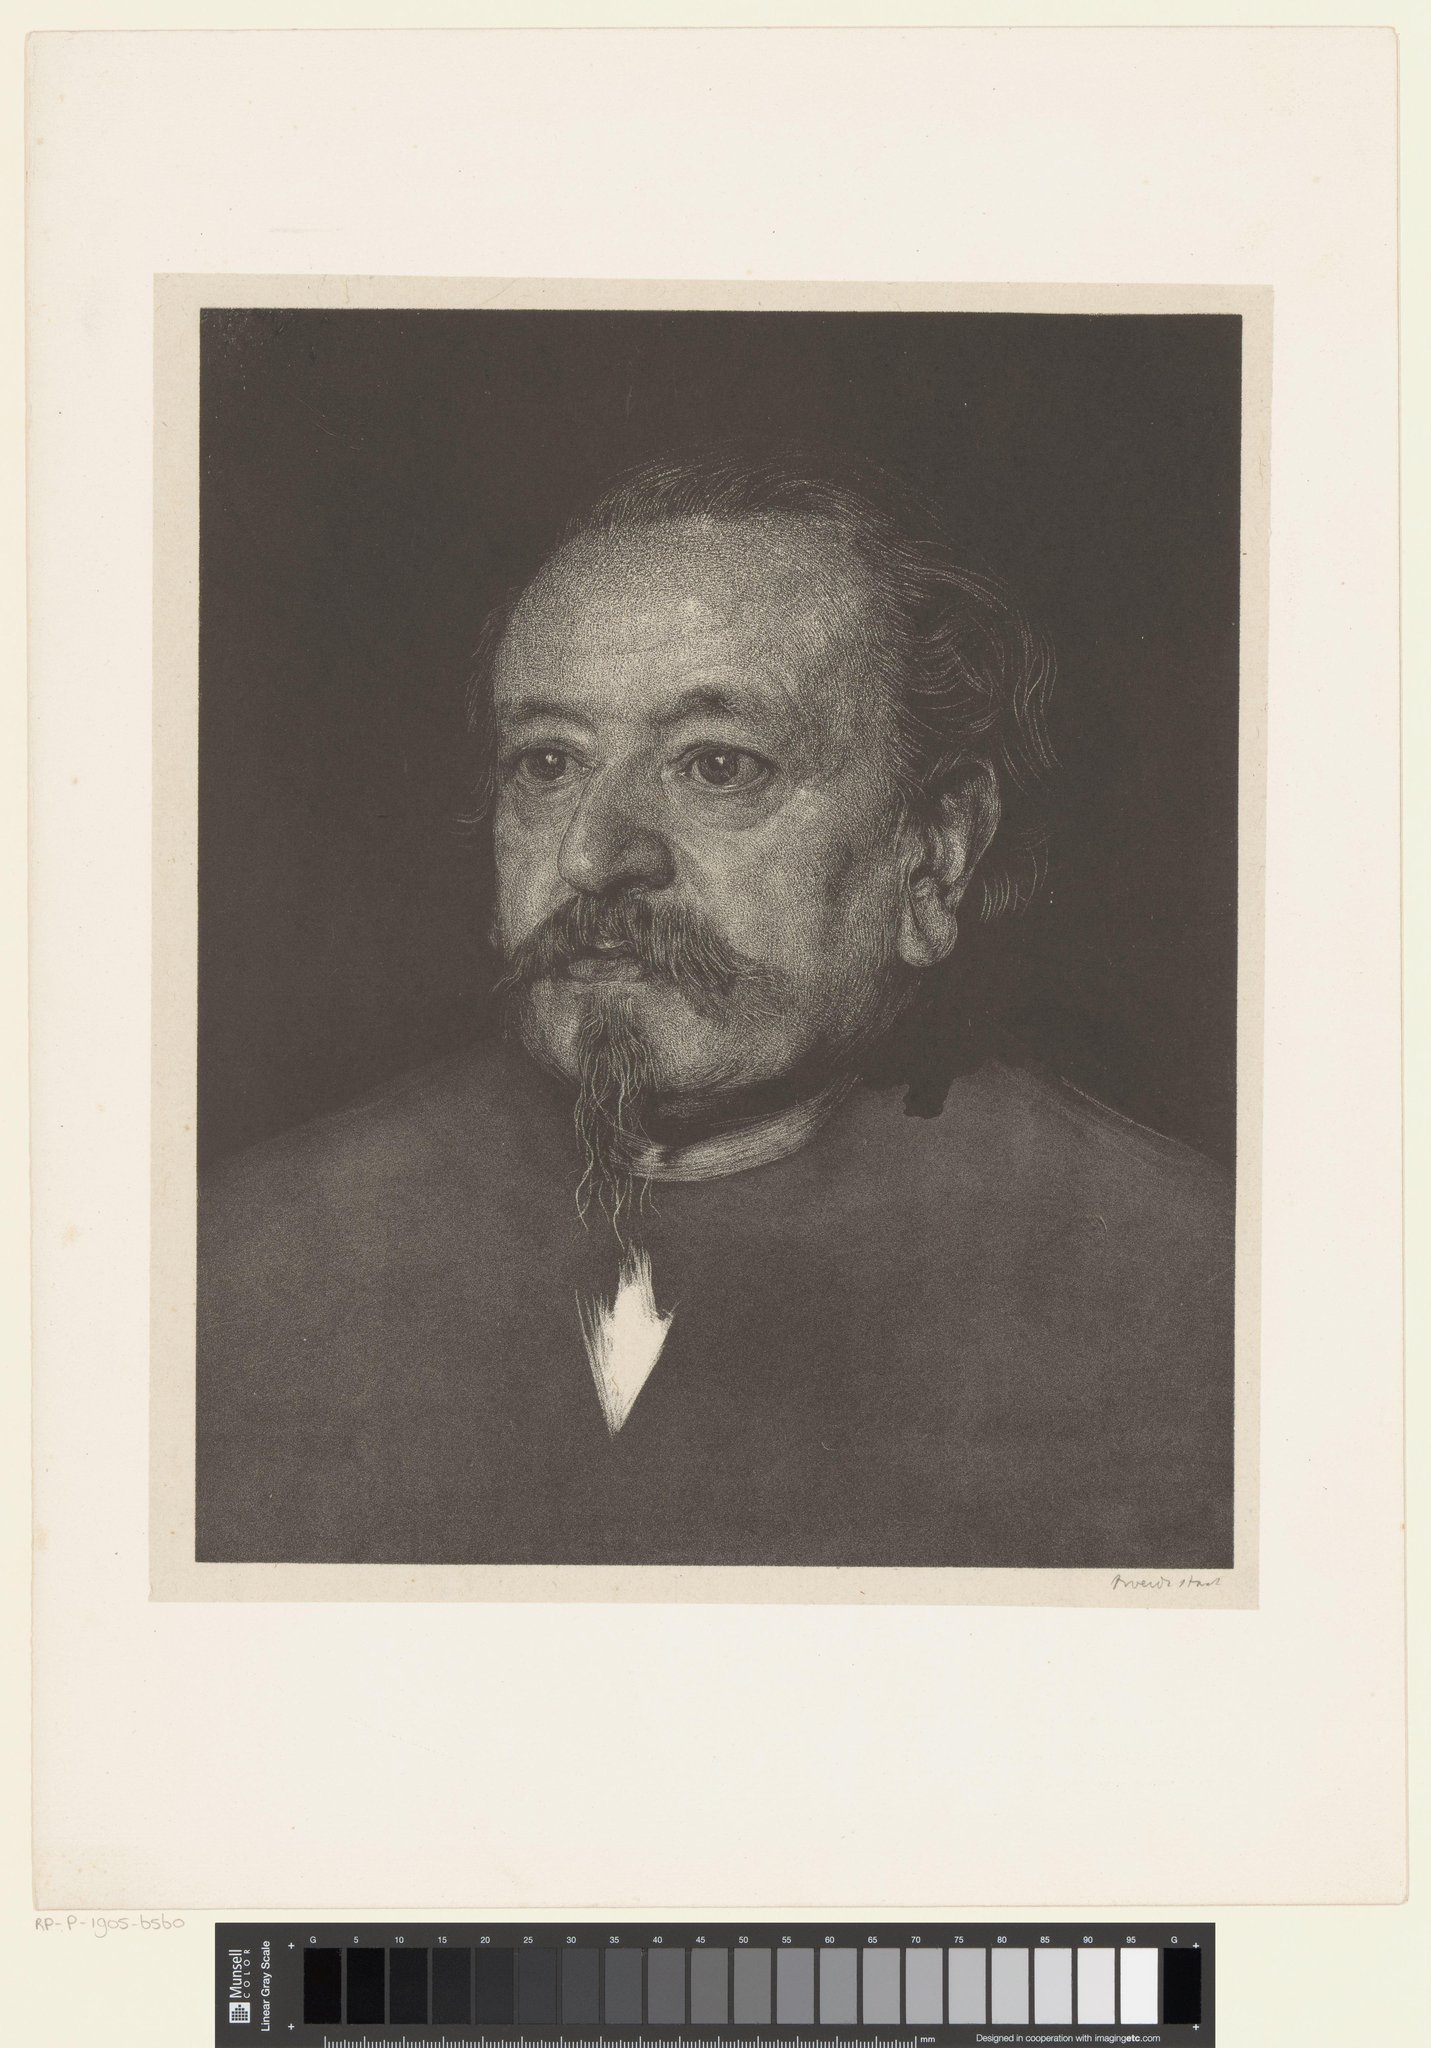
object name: print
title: Portret van Reinier Willem Petrus de Vries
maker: jan veth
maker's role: designer, draughtsman, painter, print maker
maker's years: 1864-1925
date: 1901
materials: paper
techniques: lithograph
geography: netherlands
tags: amsterdam, auctioneer, publisher, reinier willem petrus de vries (1841-1919), historical persons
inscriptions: collector's mark: Lugt 2228, inscription: ‘tweede staat’